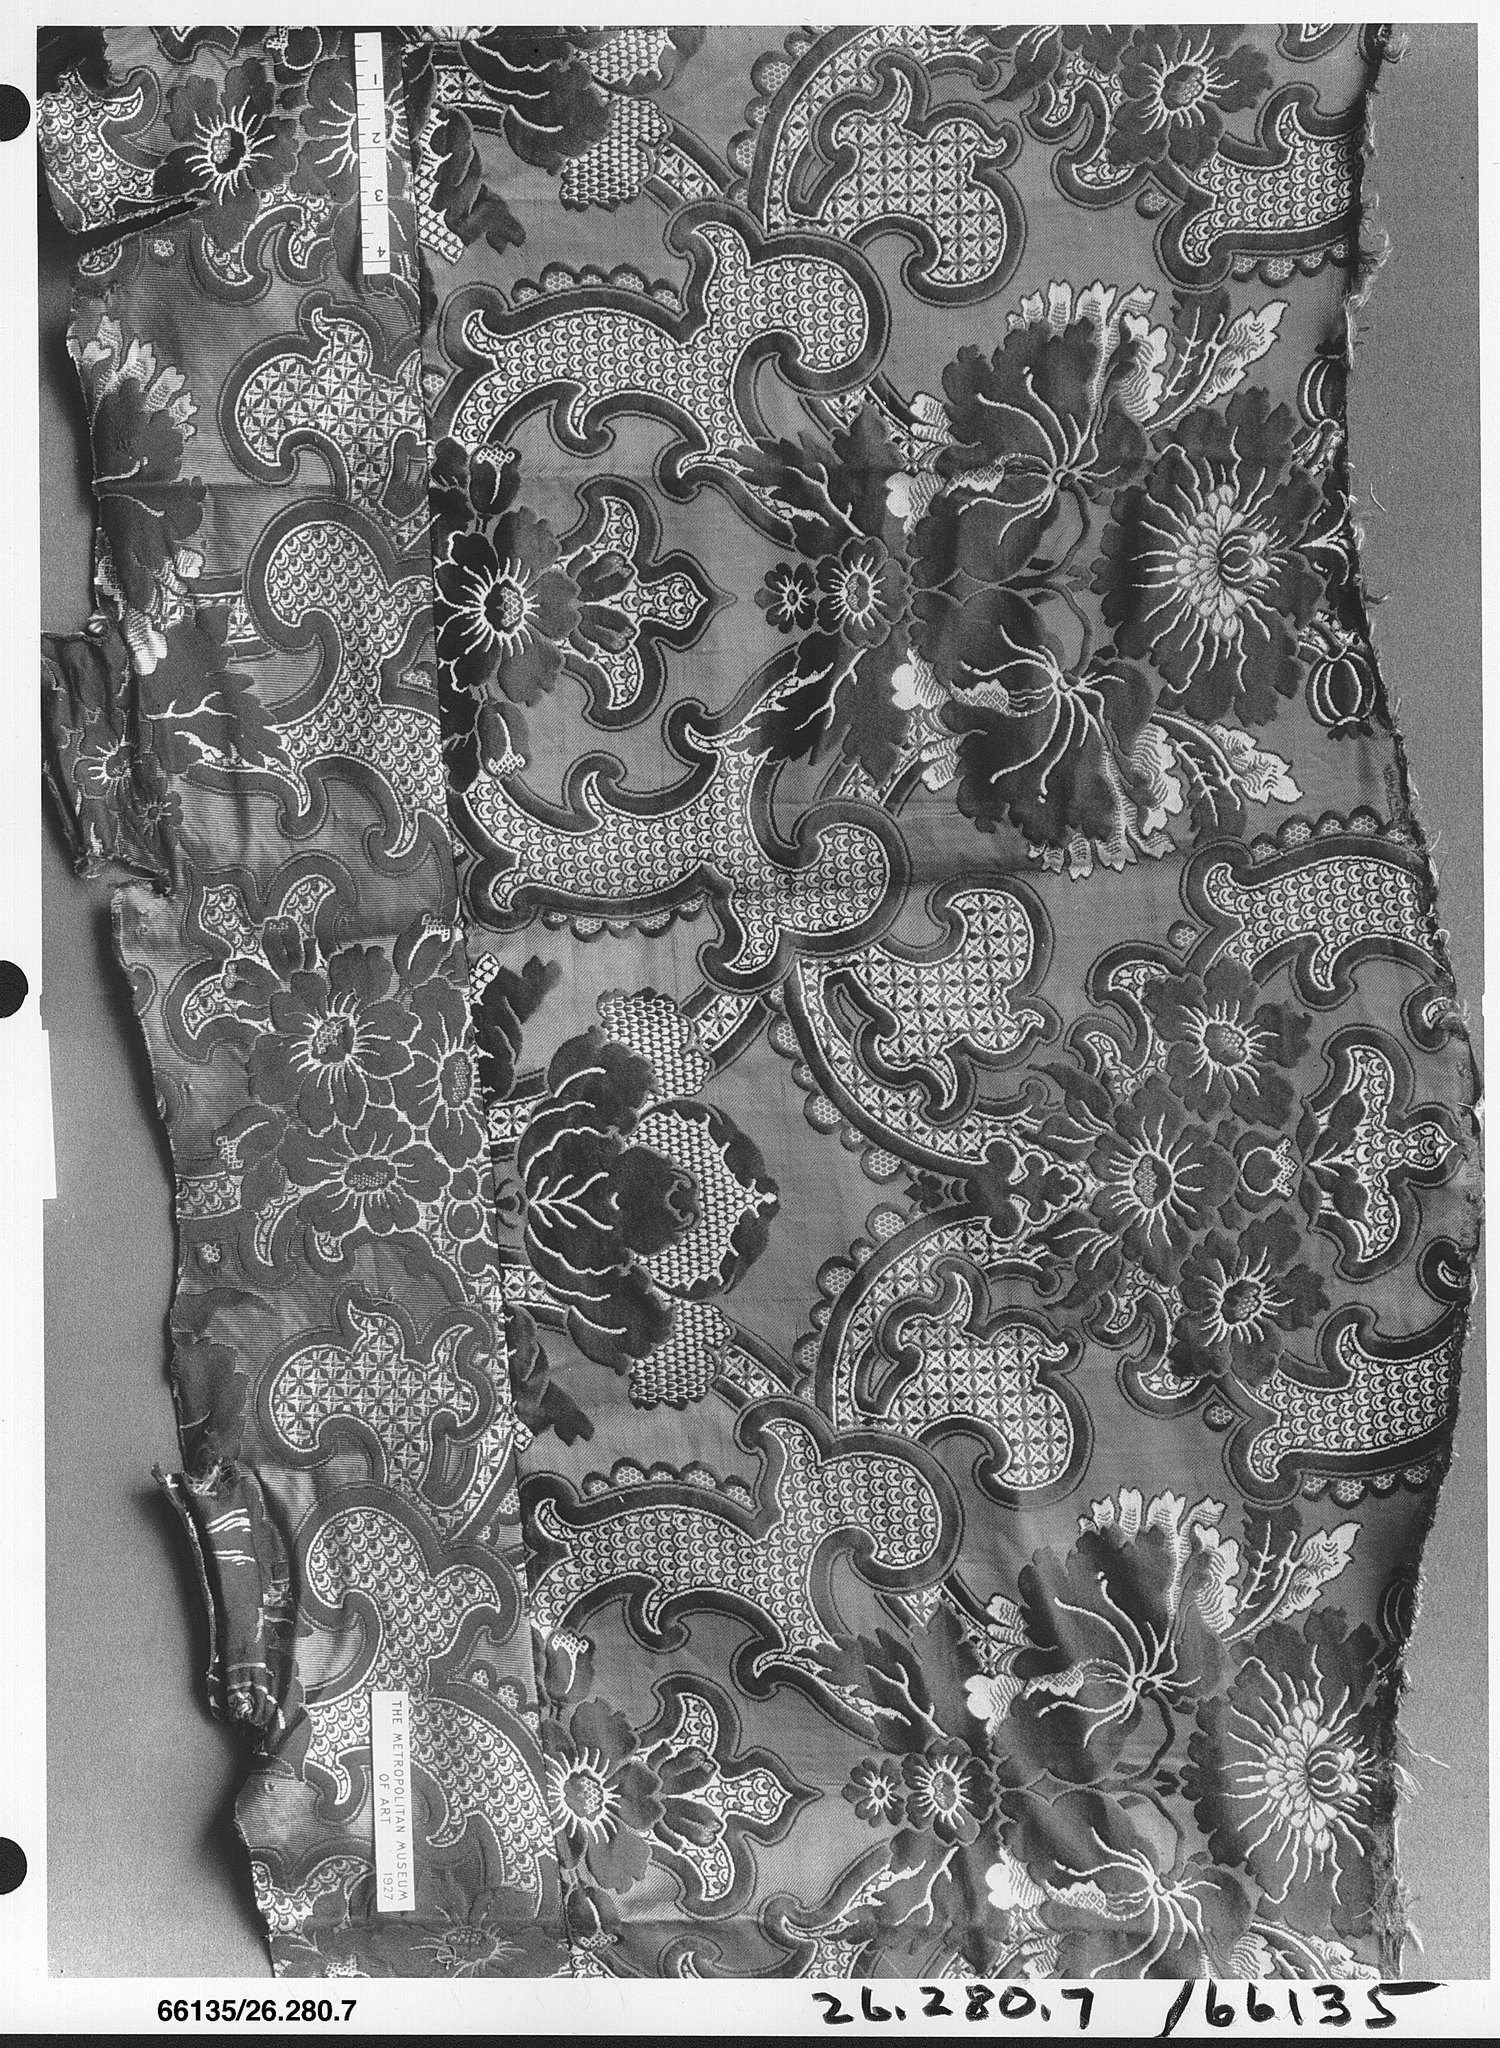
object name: piece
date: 1848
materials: silk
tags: flowers